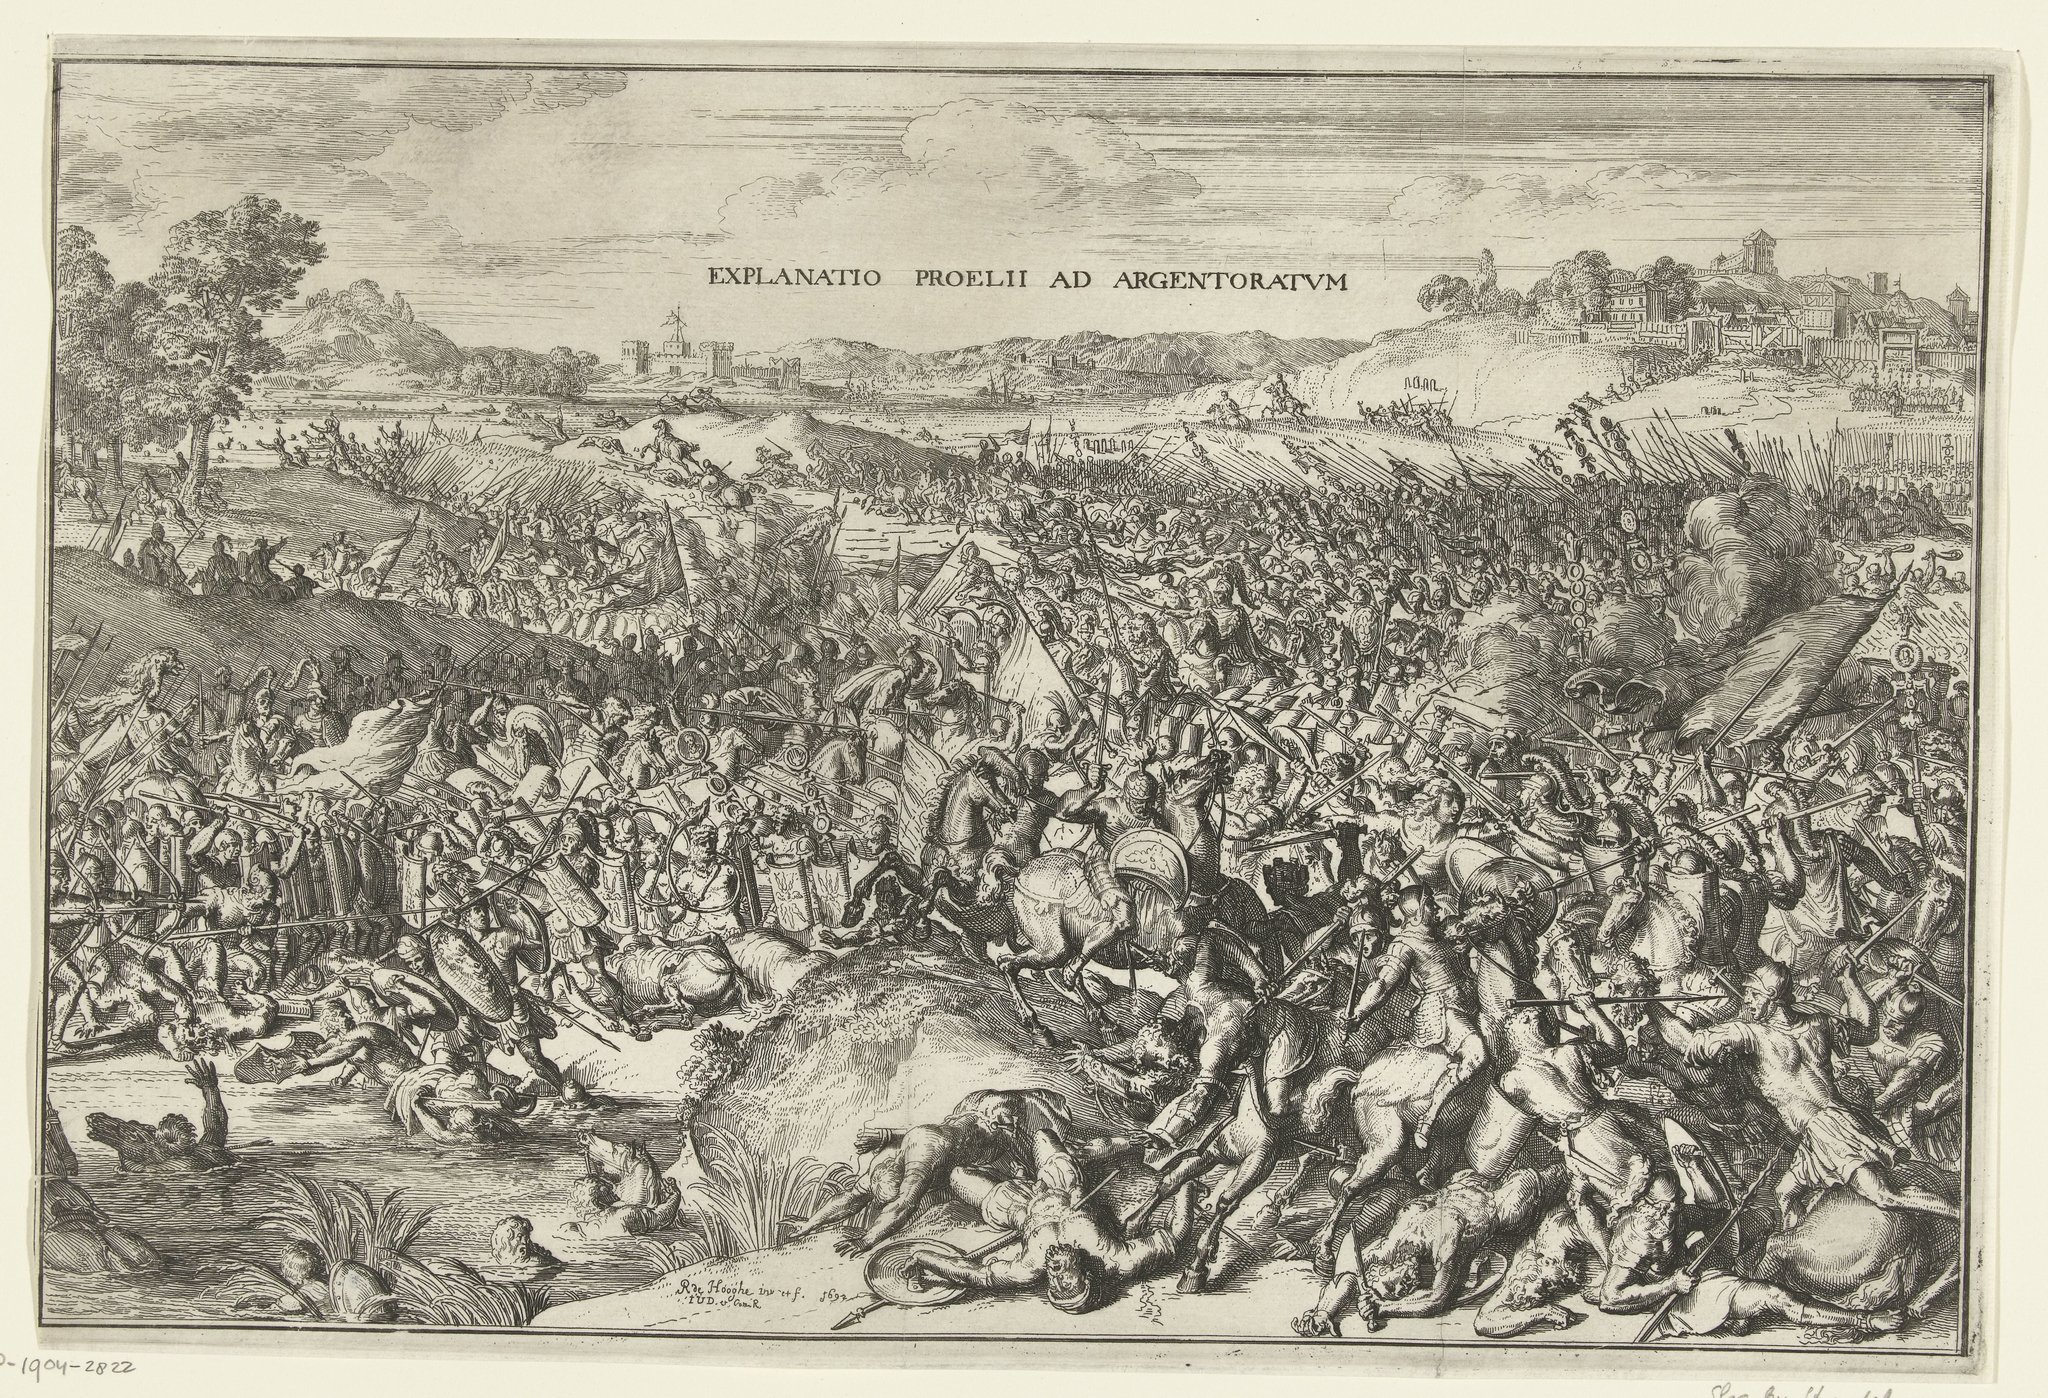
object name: history print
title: Slag bij Straatsburg, 357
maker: romeyn de hooghe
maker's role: draughtsman, goldsmith, painter, print maker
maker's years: 1645-1708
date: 1692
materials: paper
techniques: etching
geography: netherlands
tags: battle, fighting in general, extinct, 'historical' peoples (with name)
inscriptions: date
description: Slag bij Straatsburg, 357, tussen de Romeinse keizer Julianus Apostata en de Alemannen, geleid door koning Chnodomar. Gevecht tusschen ruiters en voetvolk.